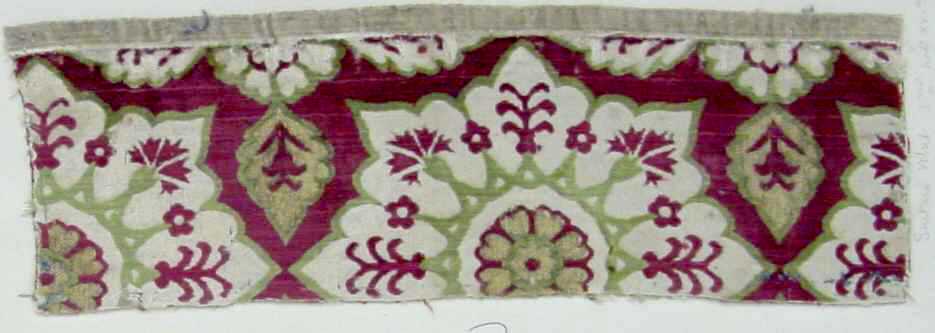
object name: textile fragment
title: Fragment of a Cushion Cover (Yastik)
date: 1501-1700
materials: metal thread, silk, velvet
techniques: brocade, cutting, voiding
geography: turkey